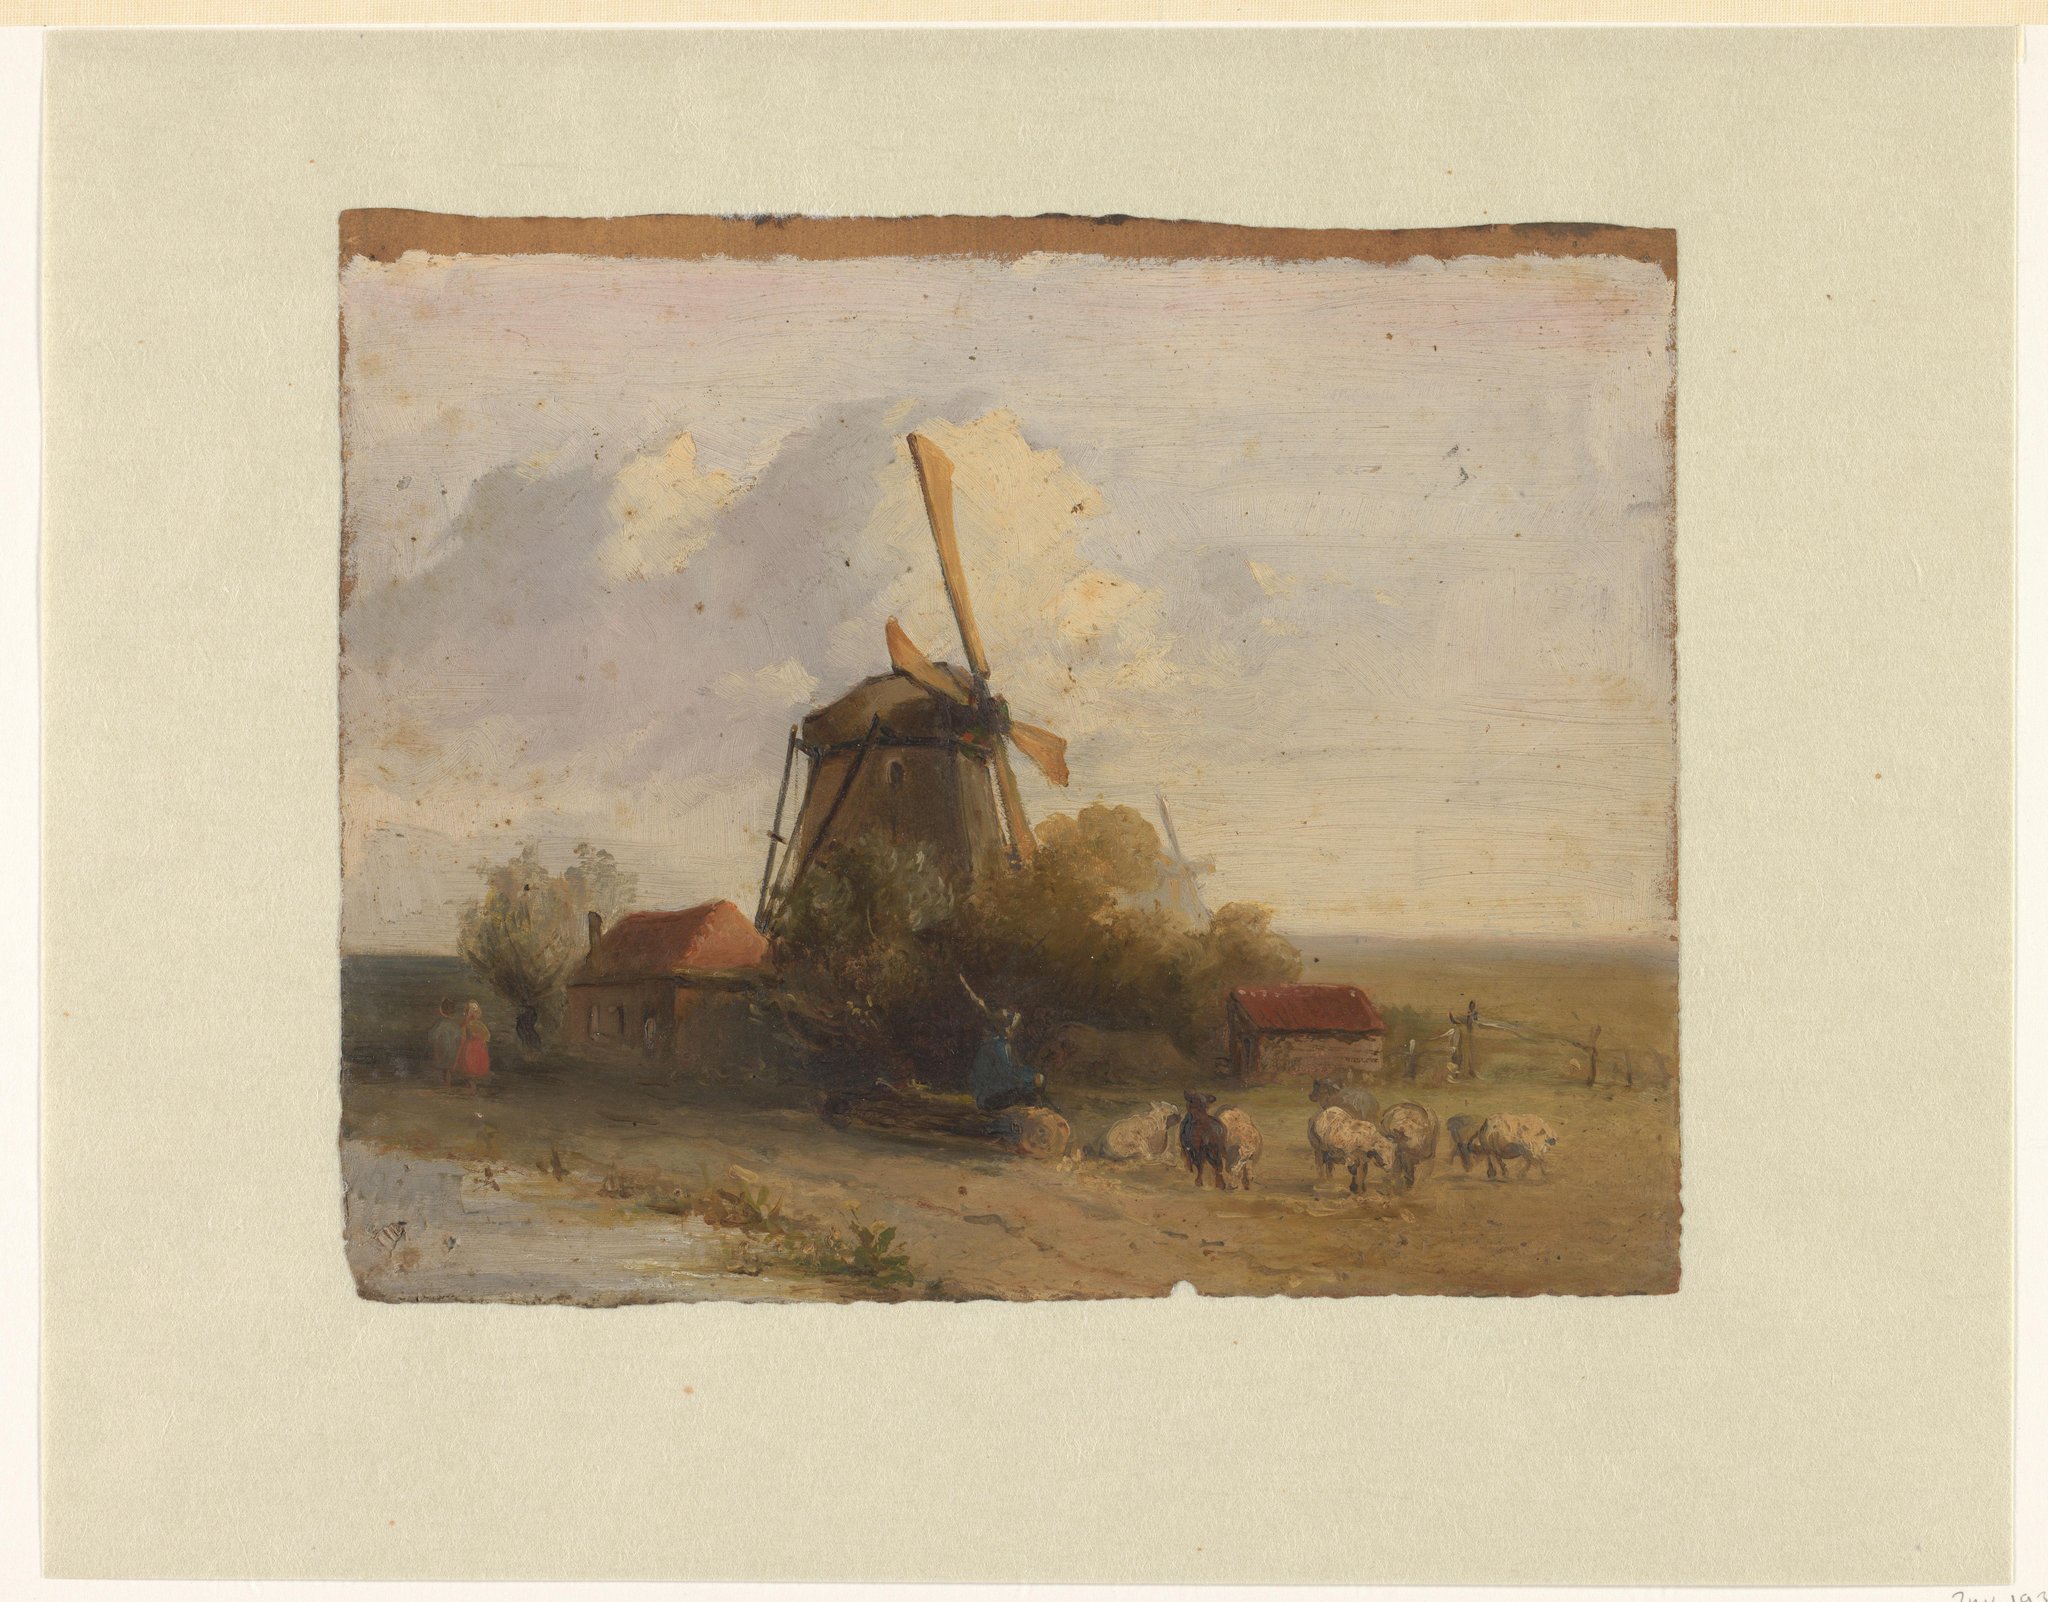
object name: drawing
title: Landschap met molen en een herder met schapen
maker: jan weissenbruch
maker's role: painter, print maker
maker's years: 1822-1880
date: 1832-1880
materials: oil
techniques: brush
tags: windmill in landscape, windmill